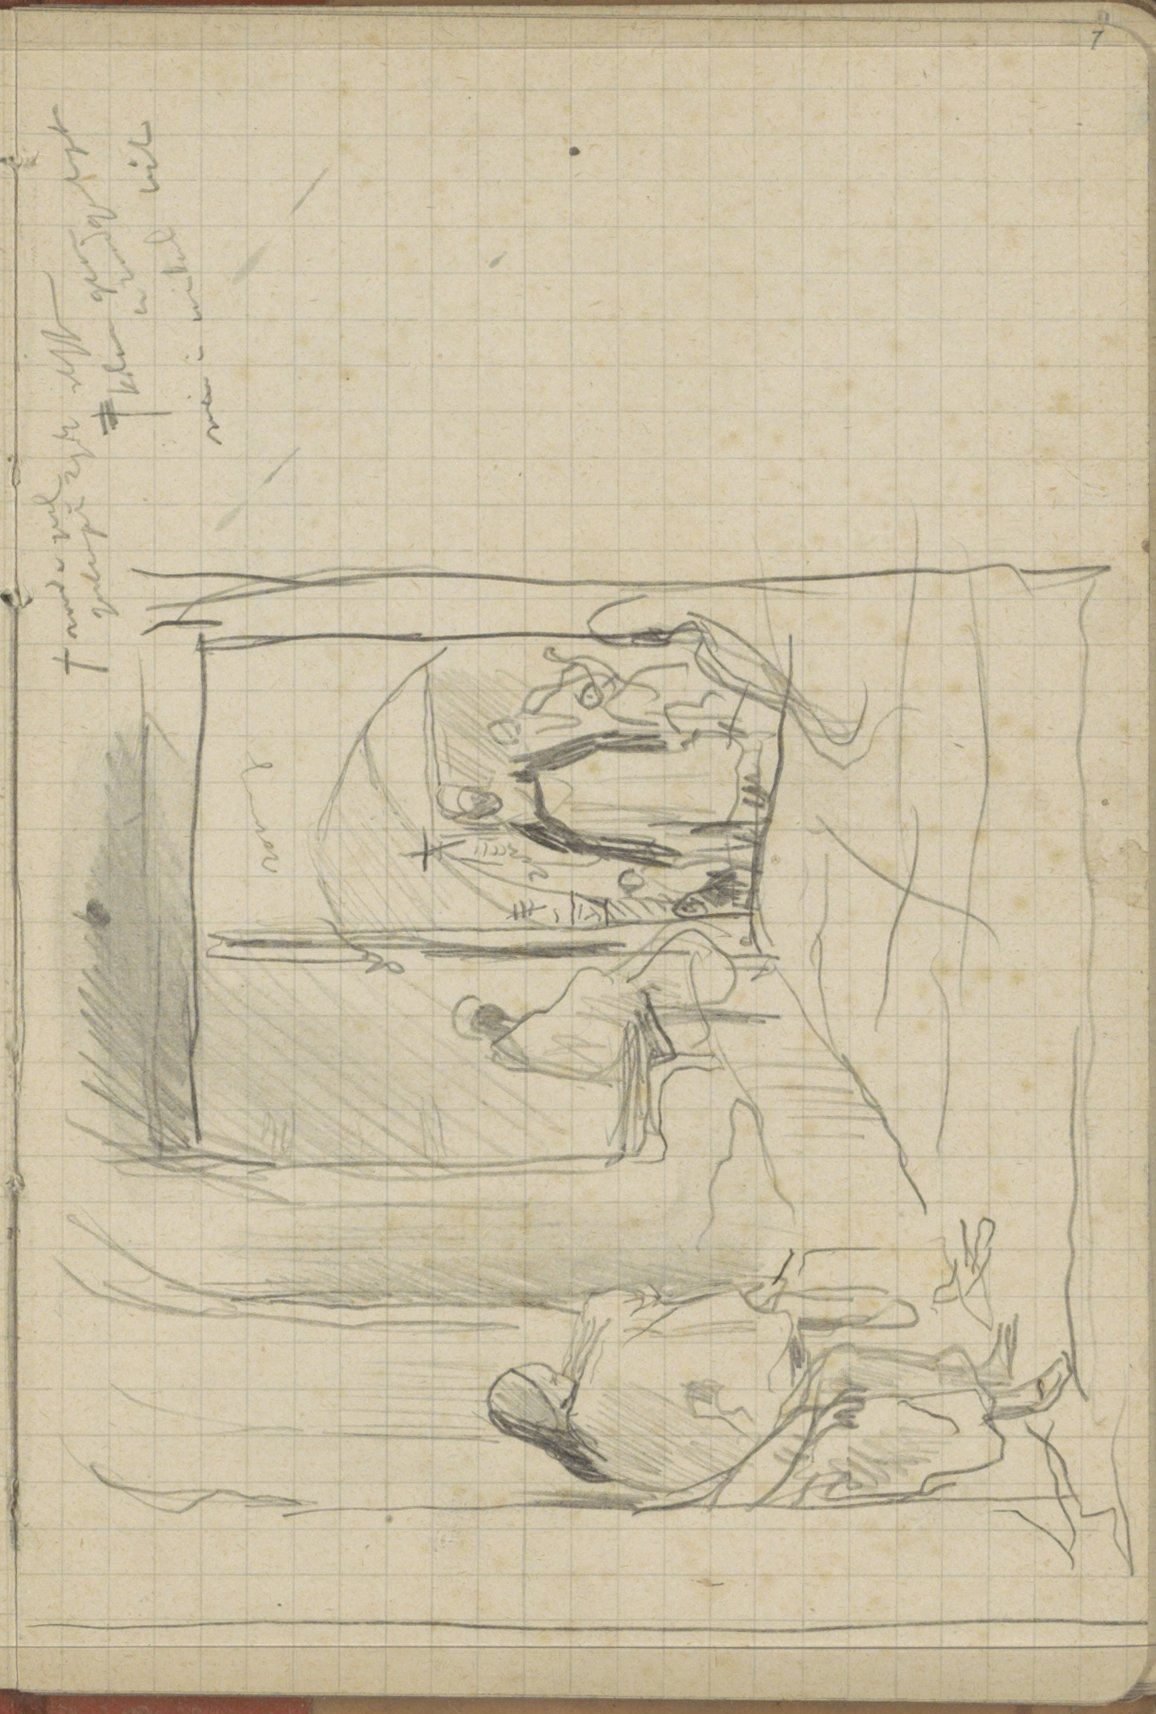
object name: sketchbook leaf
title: Steeg met zittende figuren in een nis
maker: marius bauer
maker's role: draughtsman, print maker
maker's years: 1867-1932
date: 1909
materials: pencil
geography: tunis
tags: civic architecture; edifices; dwellings, street (+ city(-scape) with figures, staffage)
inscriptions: kleurnotitie, handgeschreven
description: Op de achtergrond enkele figuren onder een rondboog. Pagina 7 uit een schetsboek met 67 bladen.